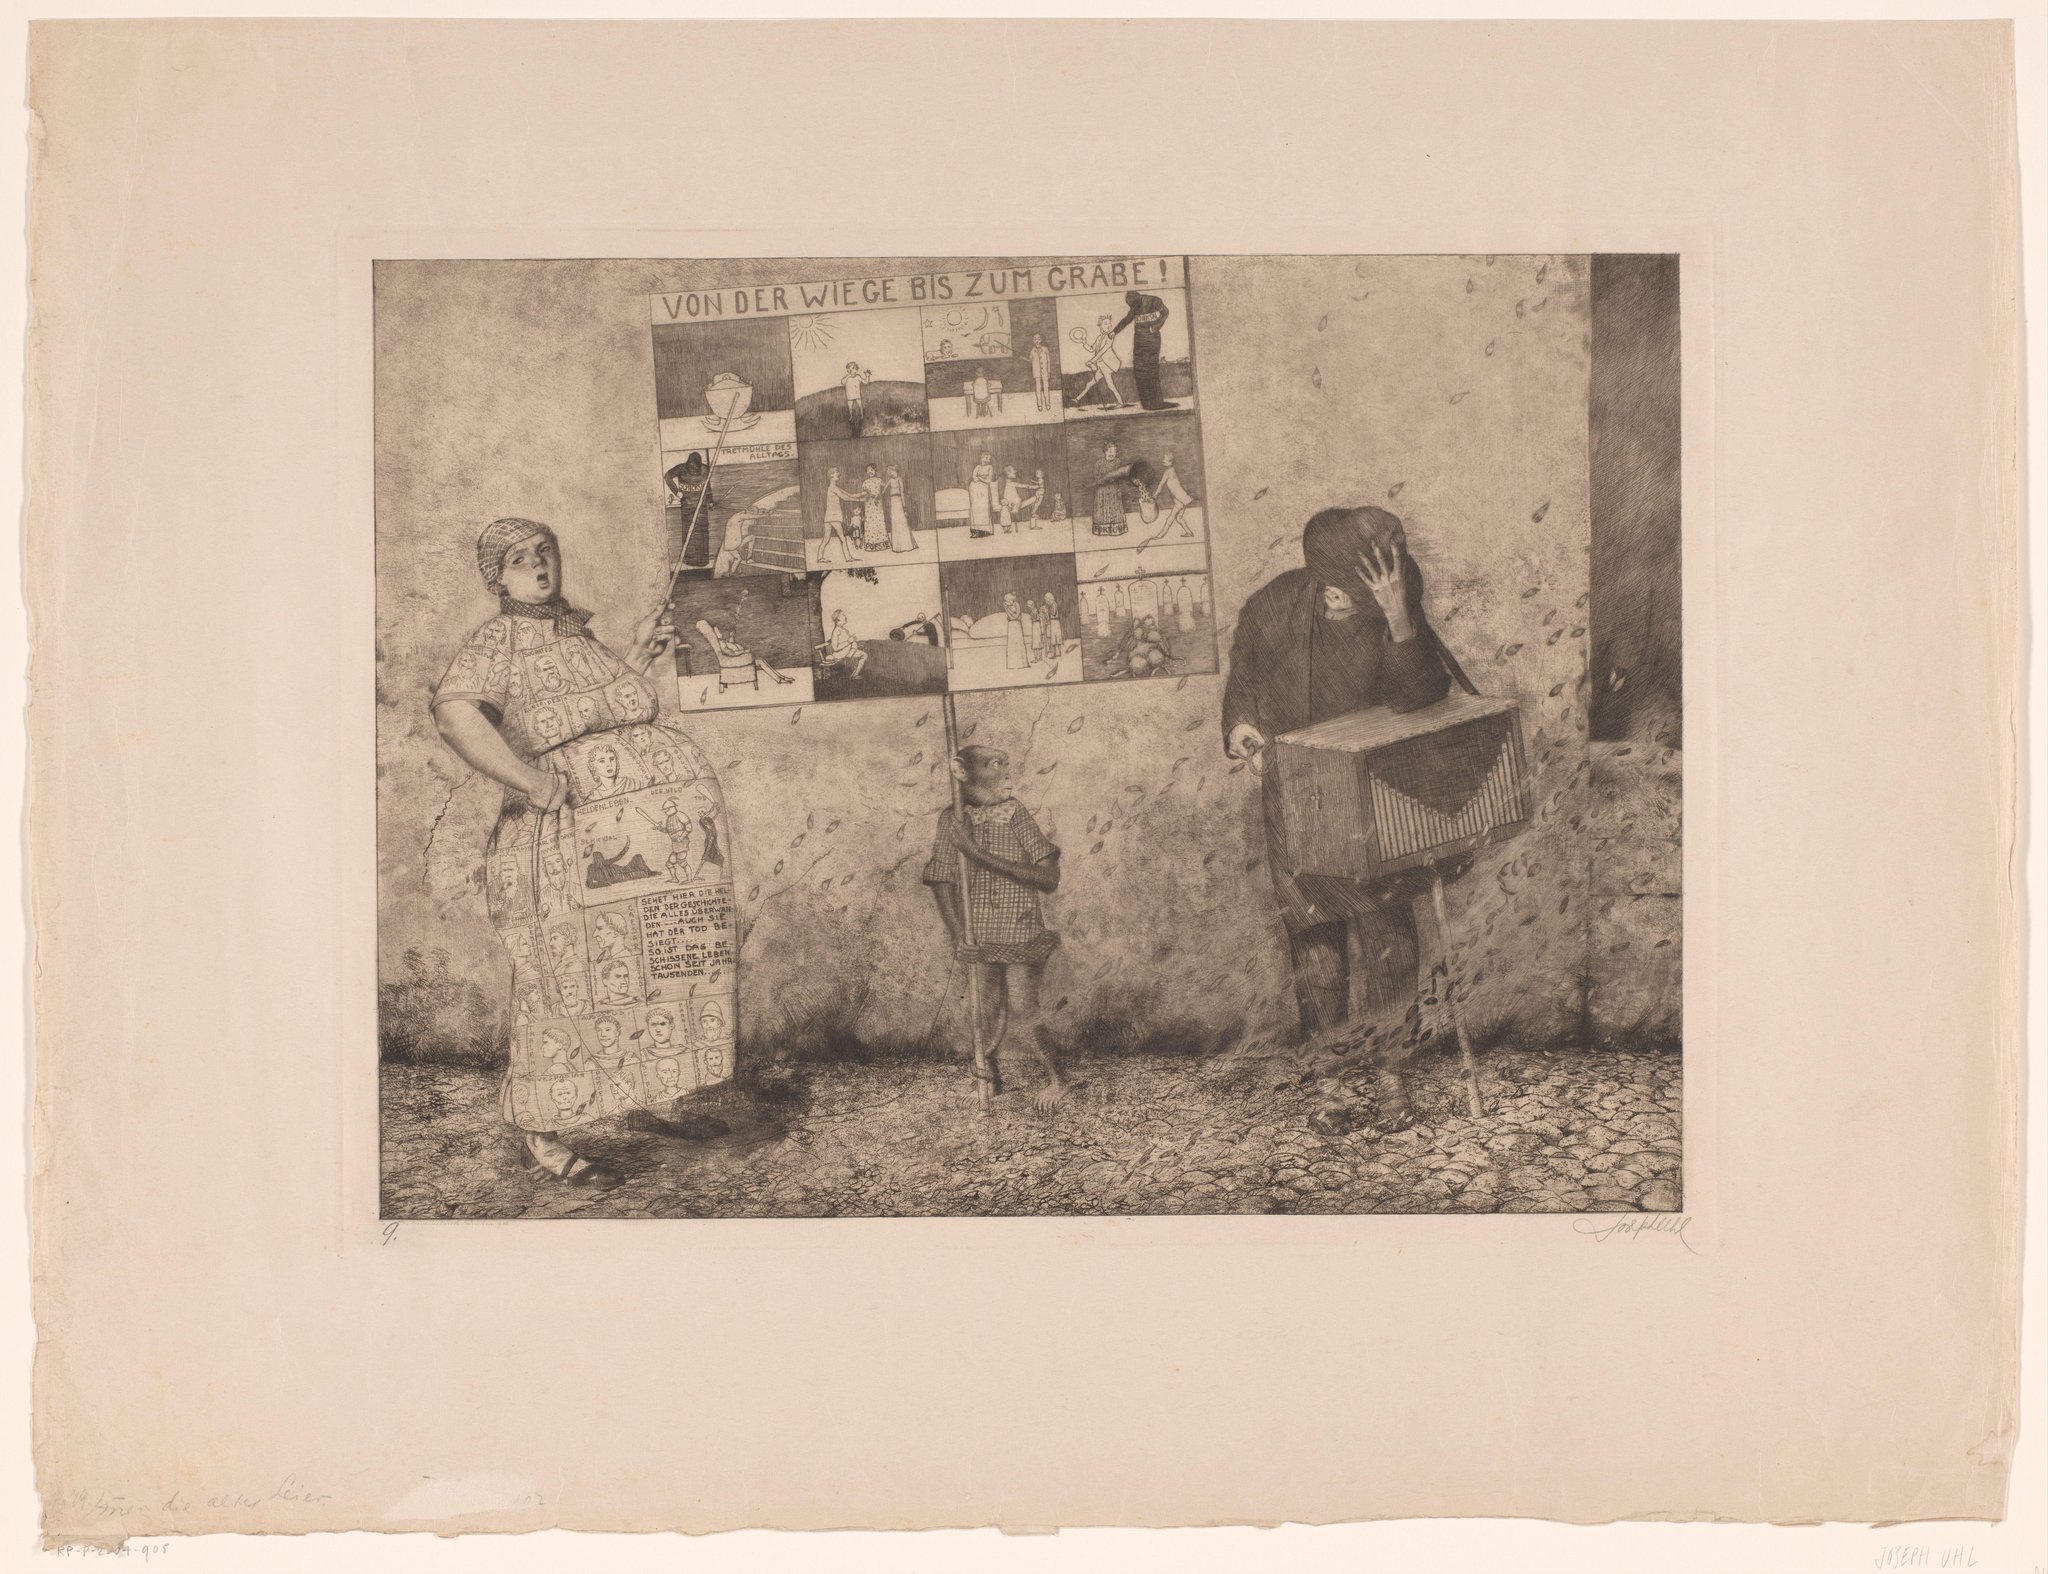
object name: print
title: Vrouw onderwijst over de levensfases van de mens, naast haar een aap en draaiorgelspeler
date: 1910-1930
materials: paper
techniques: drypoint, etching, intaglio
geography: munich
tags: monkeys, apes, organ - cc - out of doors, the ages of man, male persons from classical history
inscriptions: collector's mark: Lugt 2228, collector's mark: Lugt 2760, number: ‘9.’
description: Op de tweede staat is de titel Immer die alte Leier (altijd hetzelfde lied) vermeld.